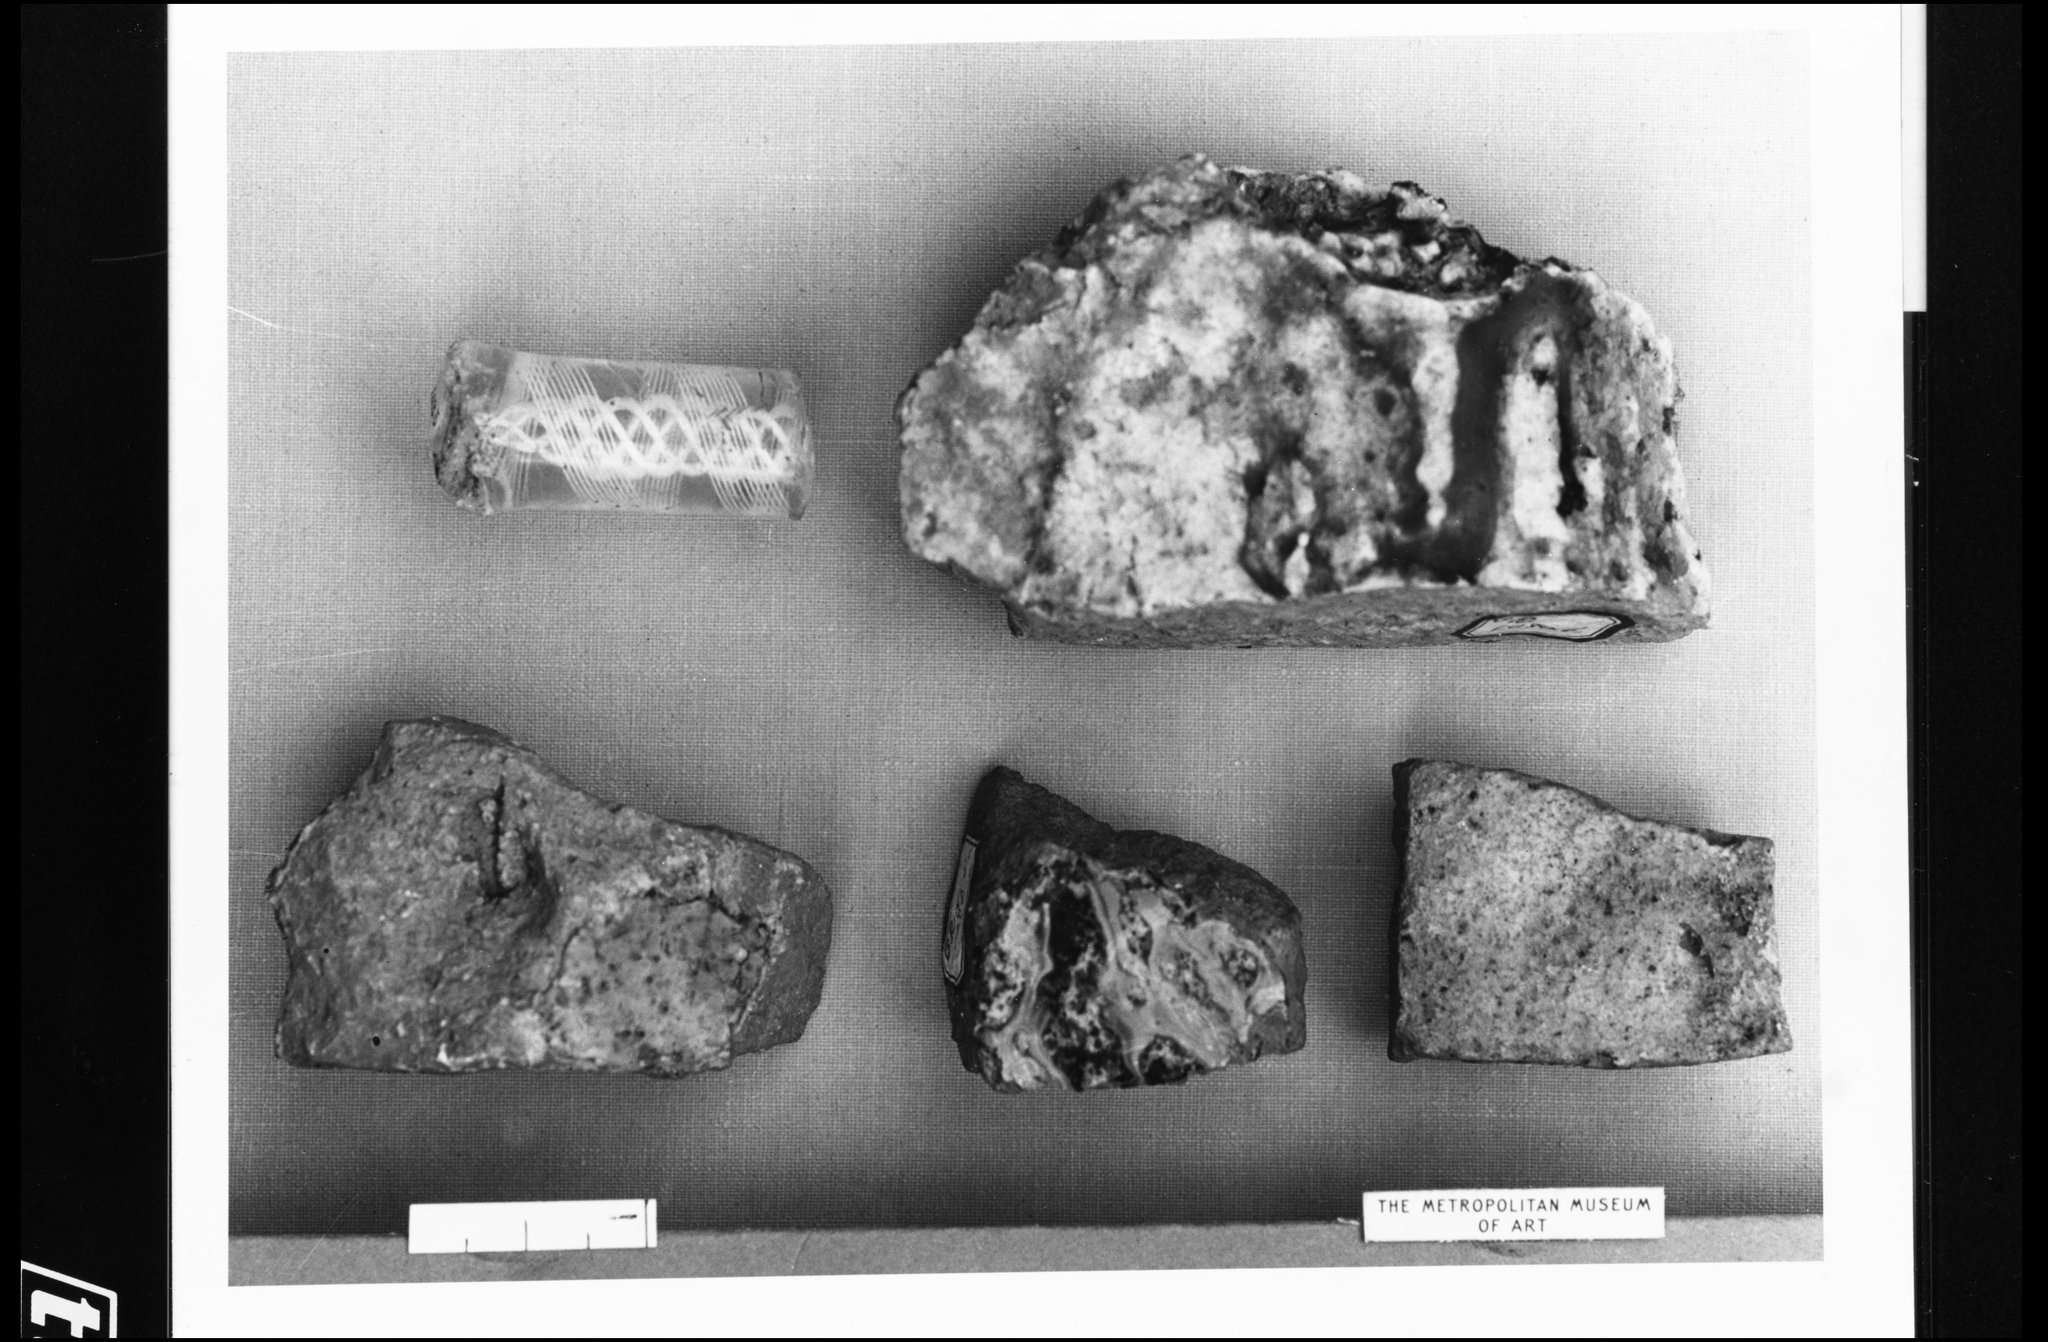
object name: fragment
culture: american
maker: stiegel's manheim factory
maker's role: maker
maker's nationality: american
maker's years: 1763-1774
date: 1763-1774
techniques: glassblowing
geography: united states